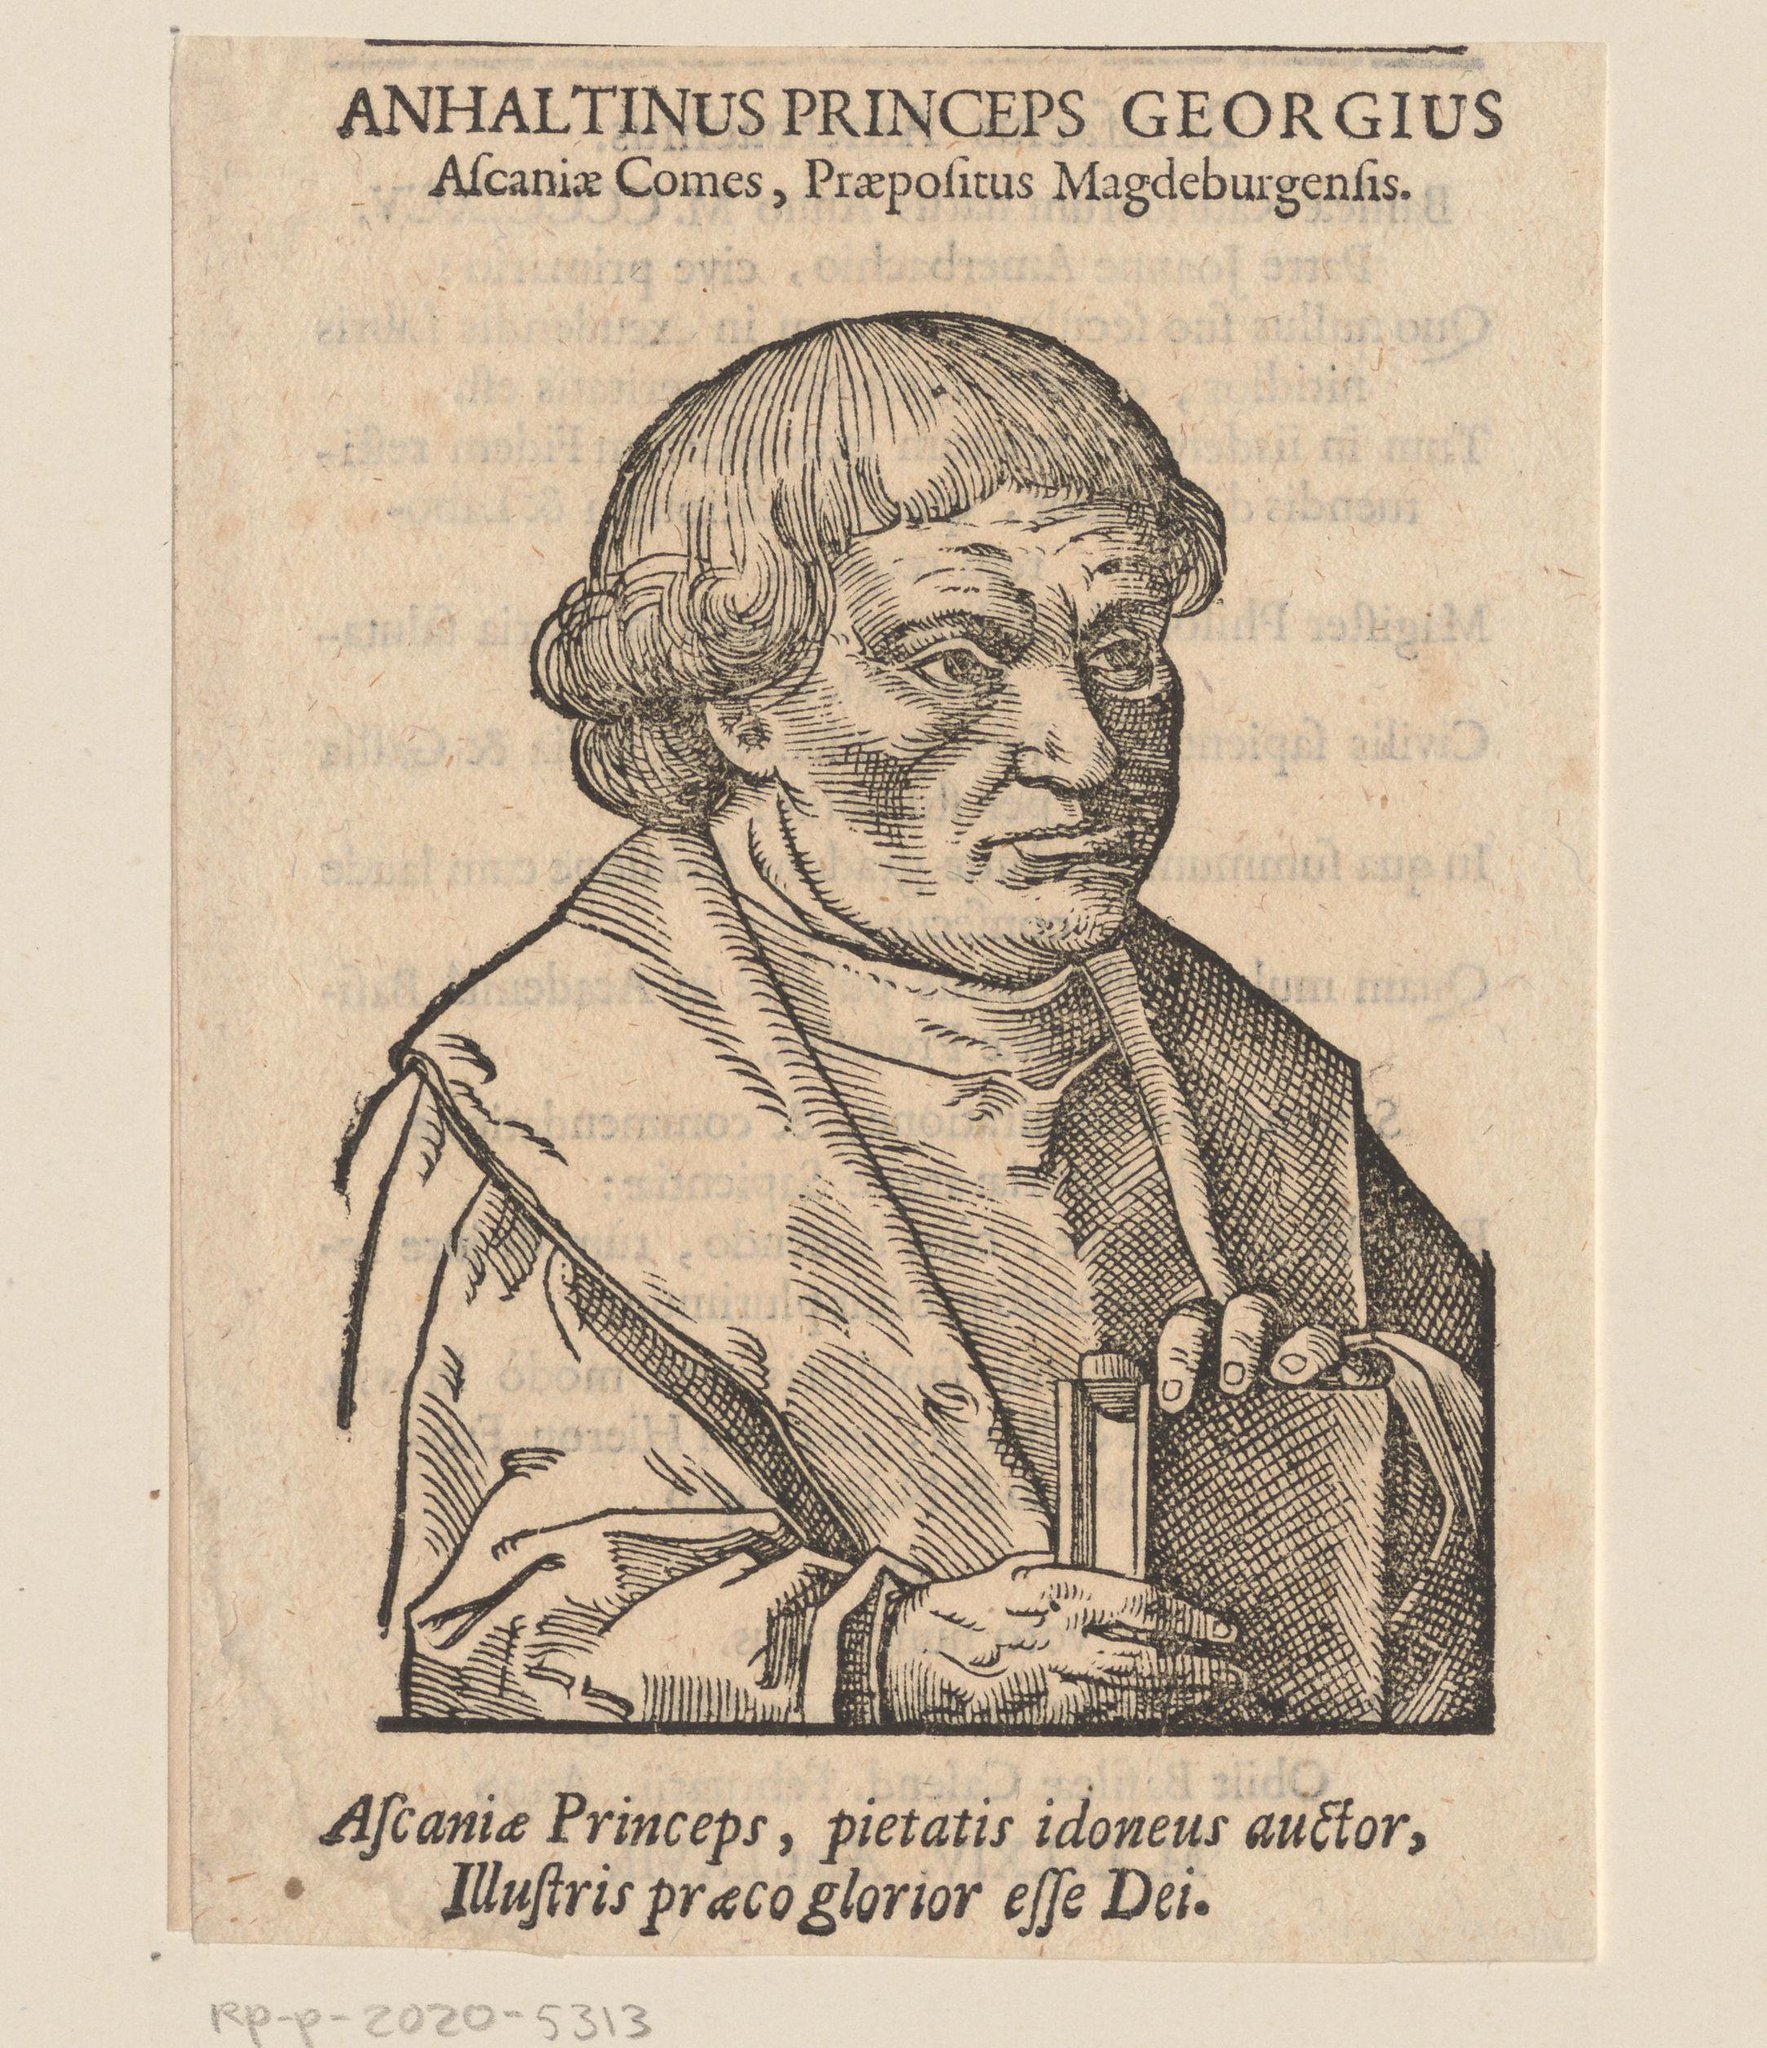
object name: print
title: Portret van Georg III von Anhalt-Plötzkau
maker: Anonymous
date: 1599-1699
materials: paper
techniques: letterpress printing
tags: historical persons, politician, e.g. party leader